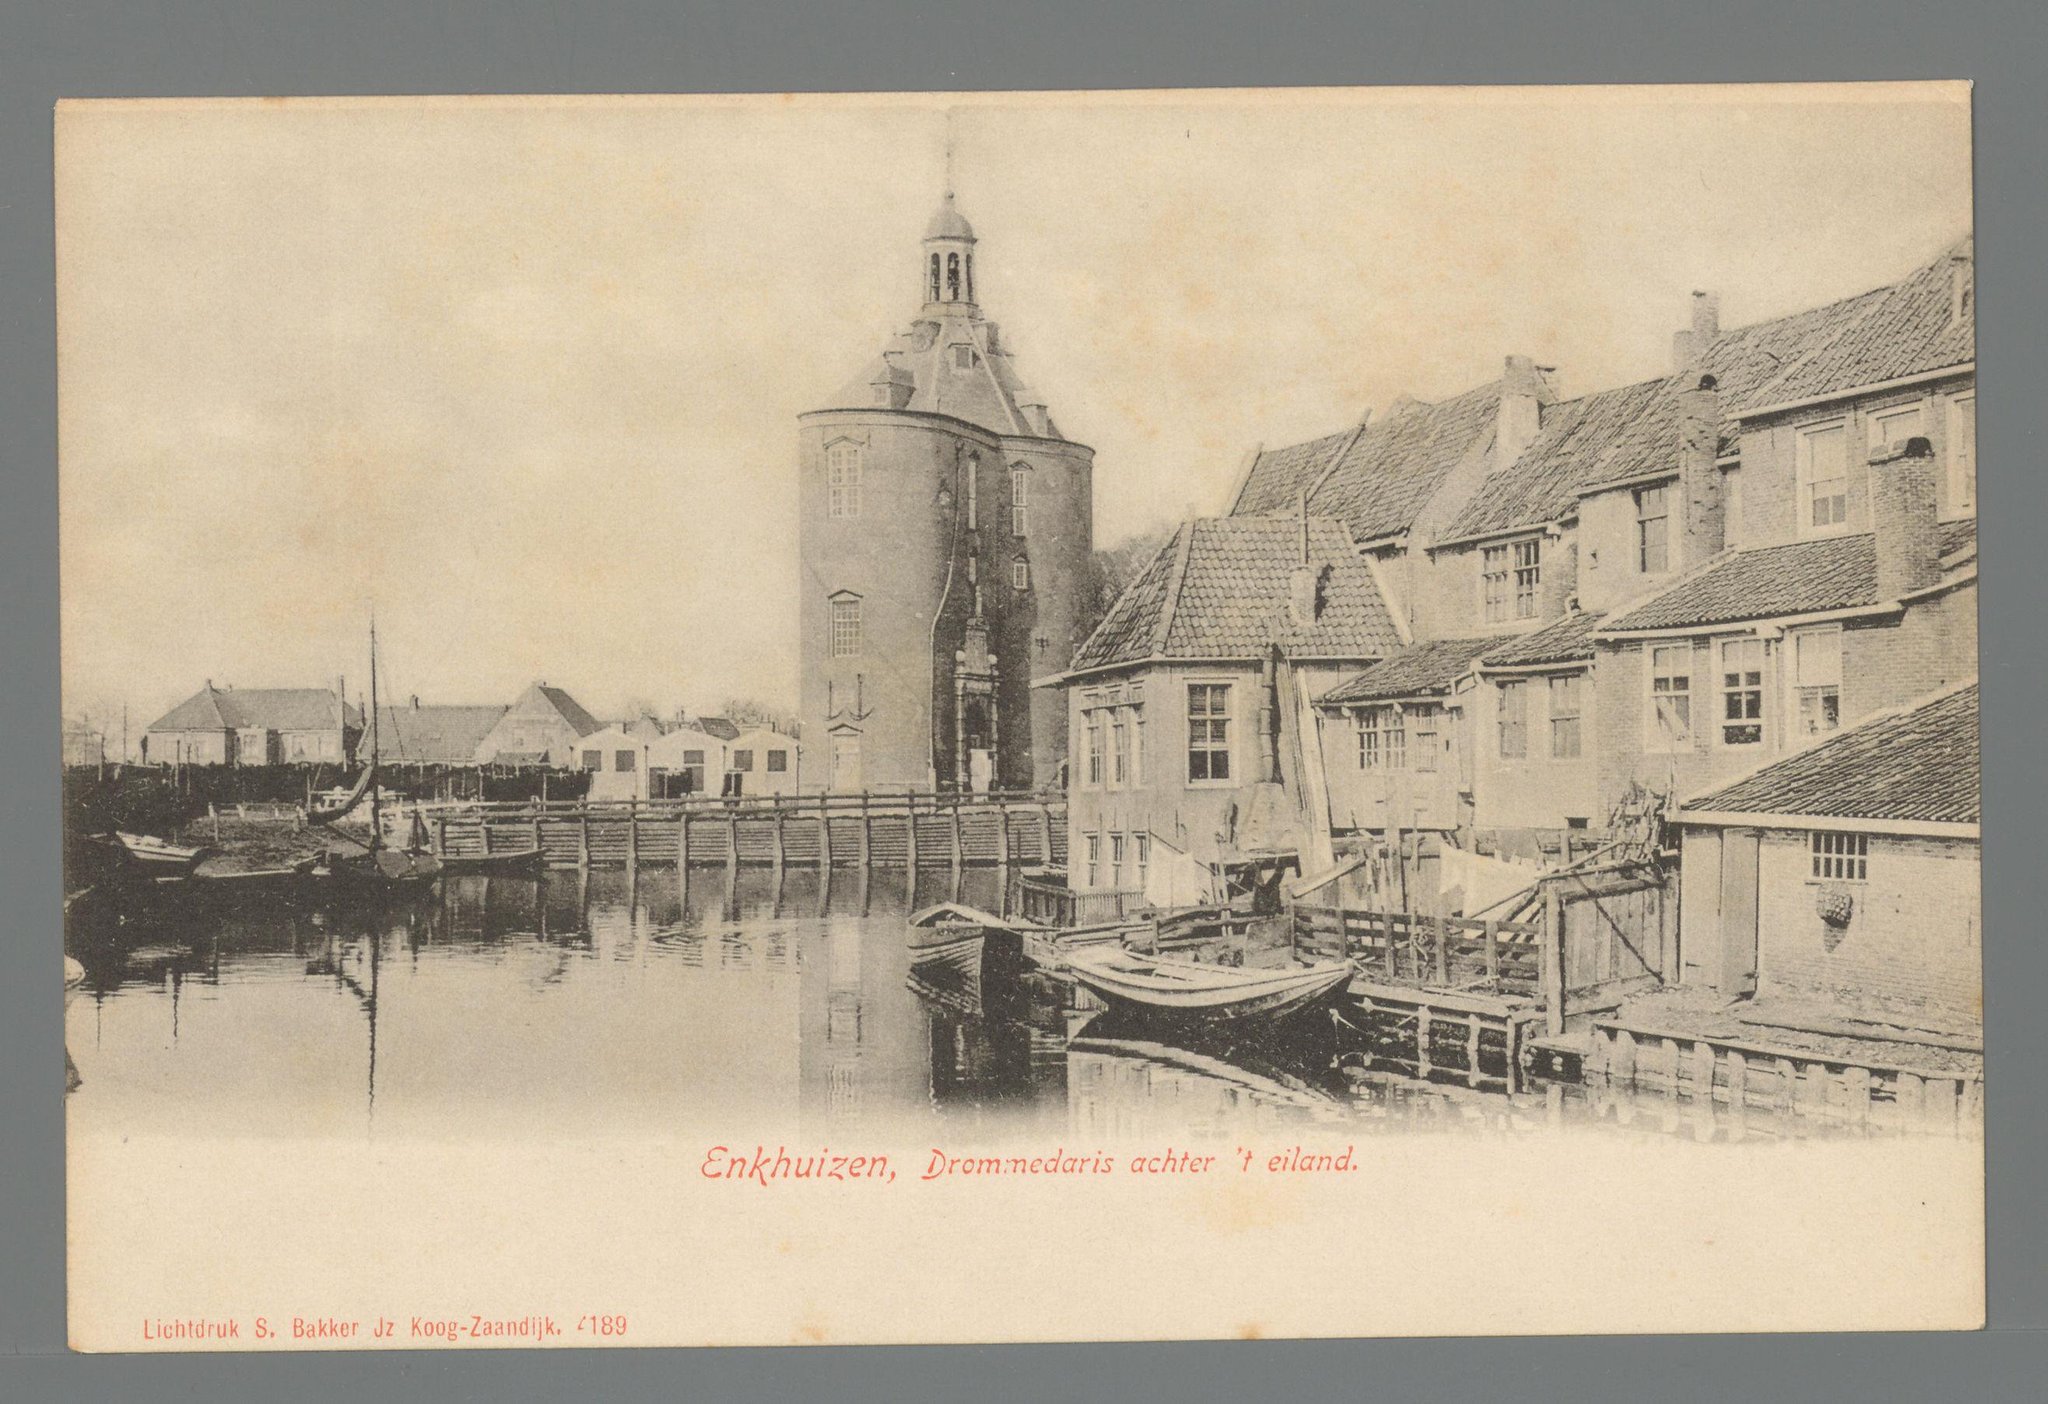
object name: photomechanical print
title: Enkhuizen, Drommedaris achter 't eiland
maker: simon bakker jz.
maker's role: printer, publisher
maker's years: 1873-1930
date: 1899-1905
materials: cardboard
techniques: photograph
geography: koog aan de zaan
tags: city-view, and landscape with man-made constructions, canal, city-gate, enkhuizen